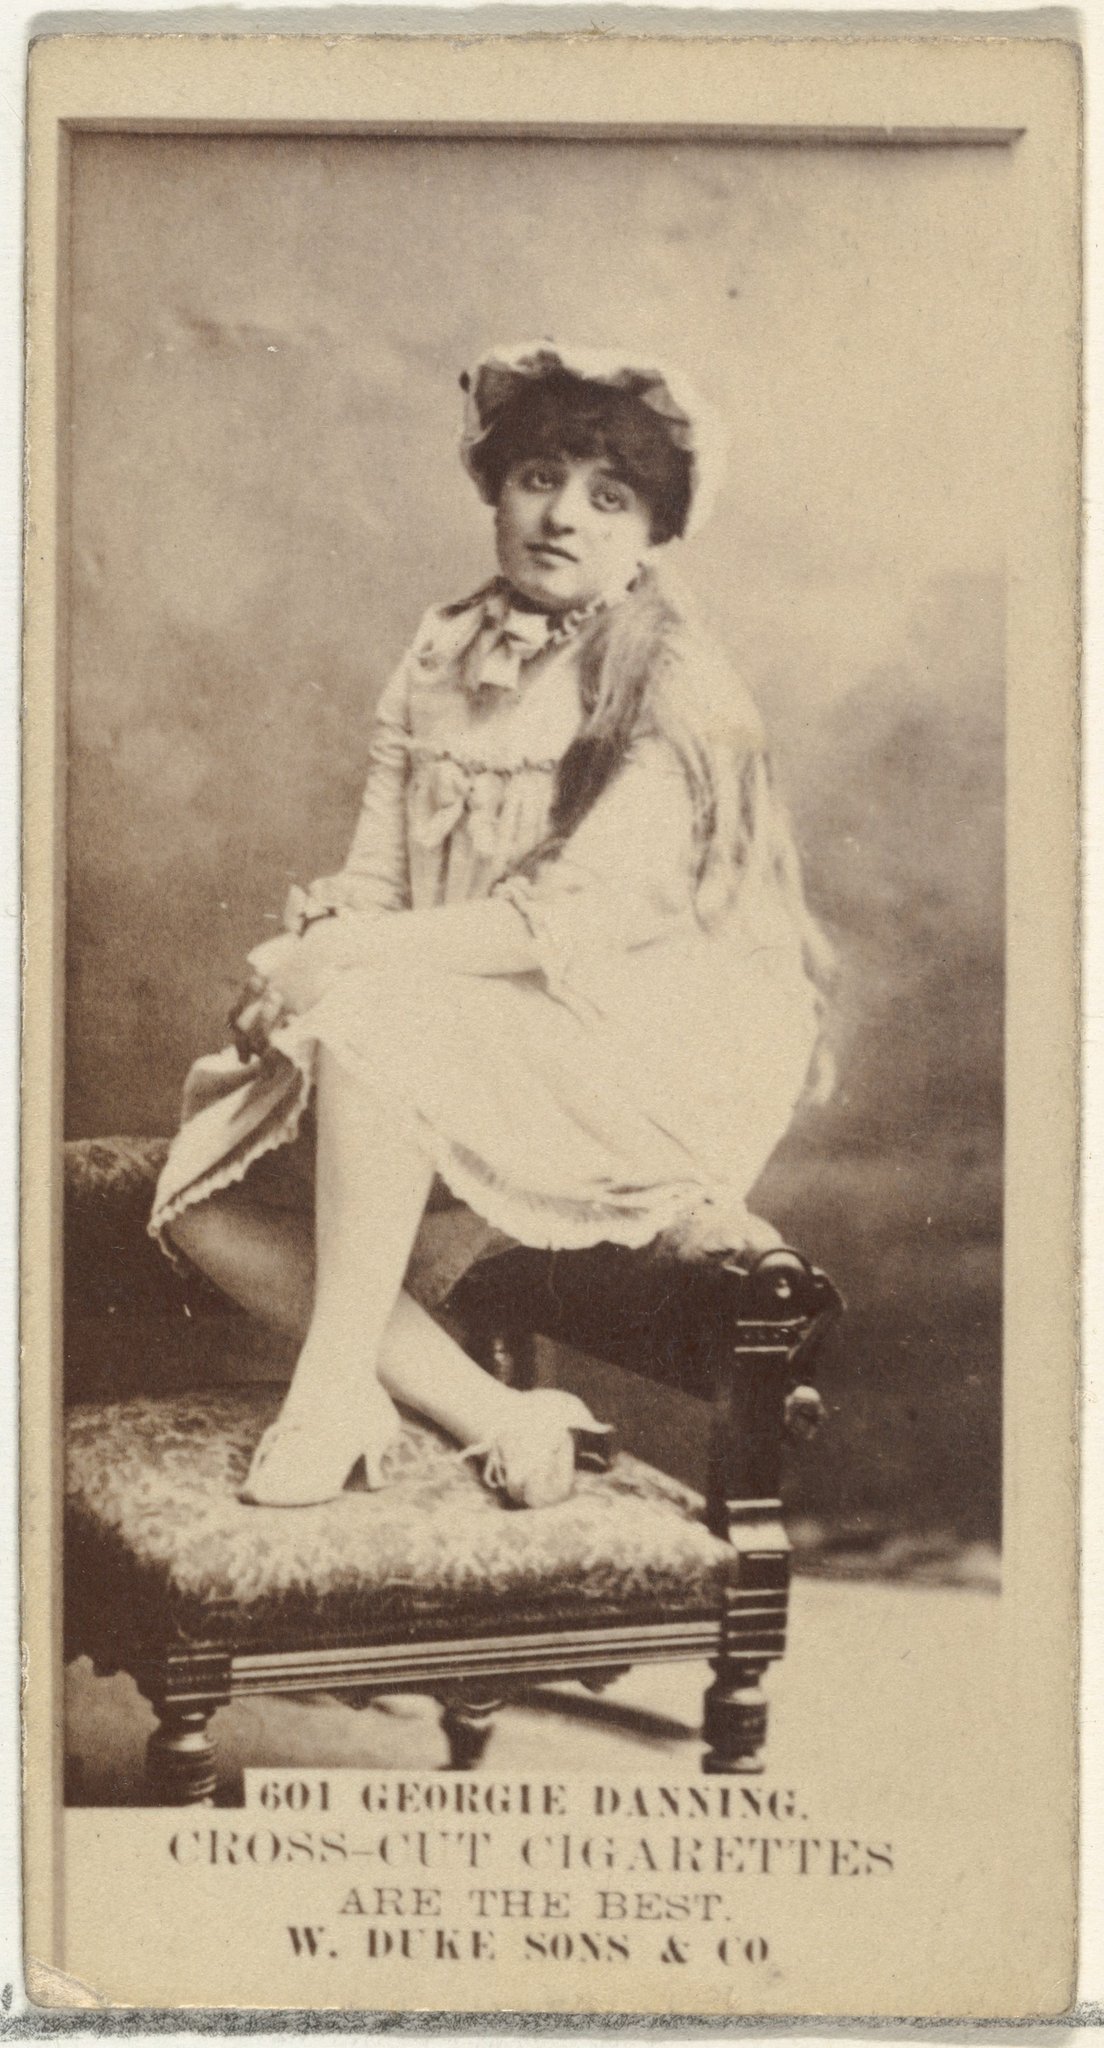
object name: photograph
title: Card Number 601, Georgie Danning, from the Actors and Actresses series (N145-3) issued by Duke Sons & Co. to promote Cross Cut Cigarettes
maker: w. duke, sons & co.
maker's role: publisher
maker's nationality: american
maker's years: 1870-1920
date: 1880-1889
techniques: albumen silver print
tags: portraits,women,actresses